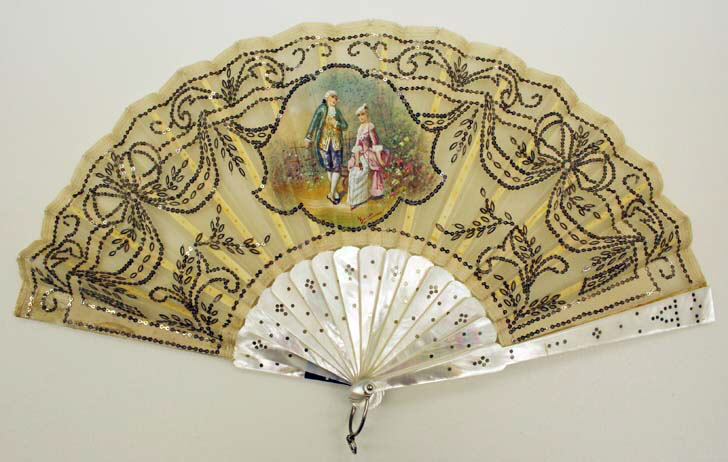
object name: fan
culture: american or european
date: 1867-1900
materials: metal, mother of pearl, silk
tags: men,women